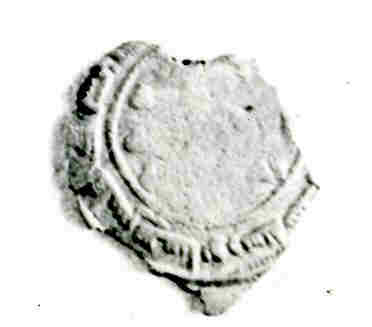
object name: coin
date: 701-900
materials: copper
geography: iran